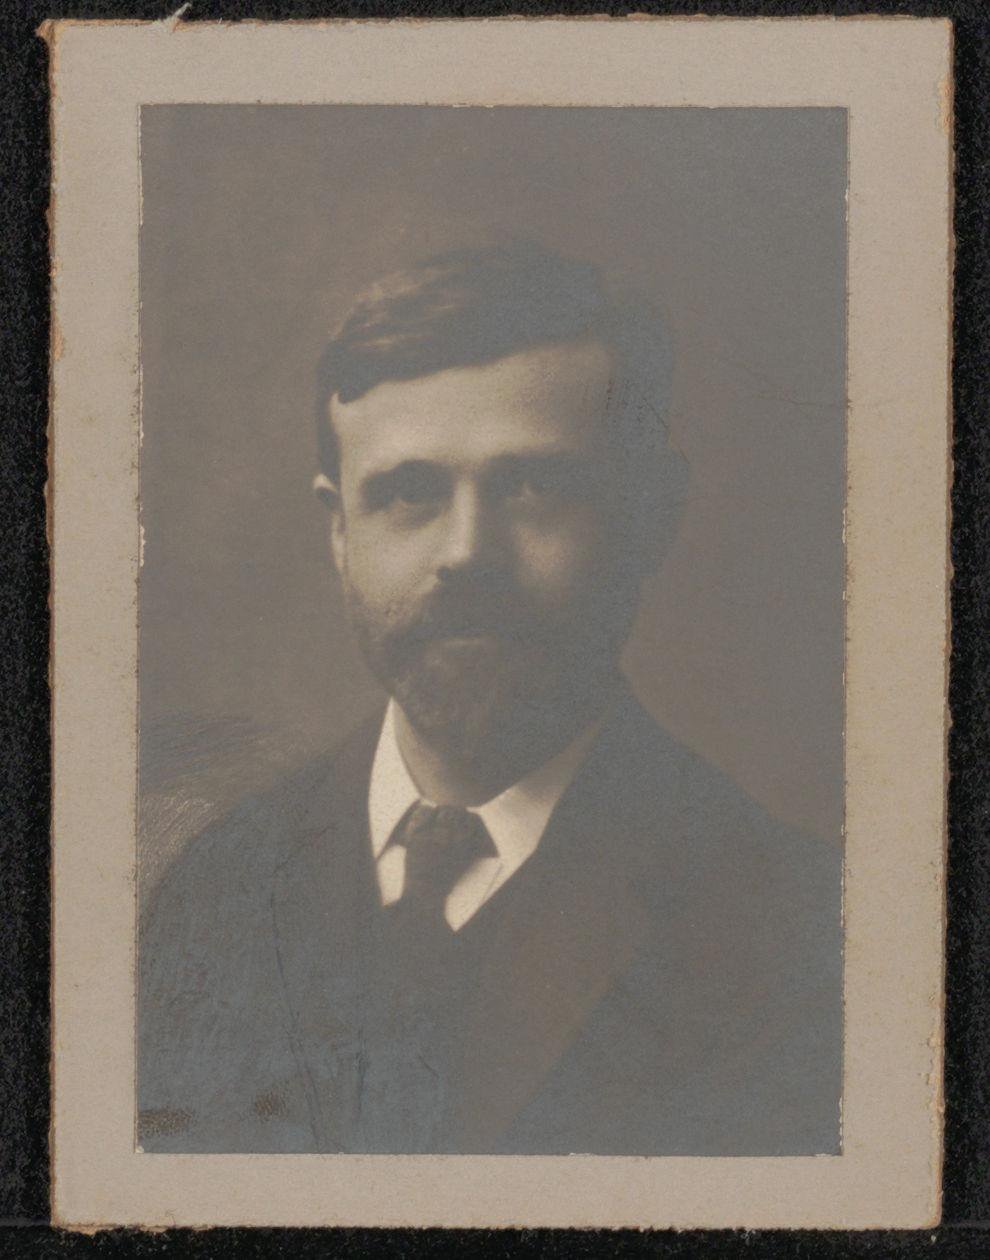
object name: photograph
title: Portret van Pieter Dupont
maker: Anonymous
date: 1890-1911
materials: photographic support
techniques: gelatin silver print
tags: amsterdam, print maker, draughtsman, pieter dupont, historical persons (portraits and scenes from the life)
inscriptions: collector's mark: ‘RPK’